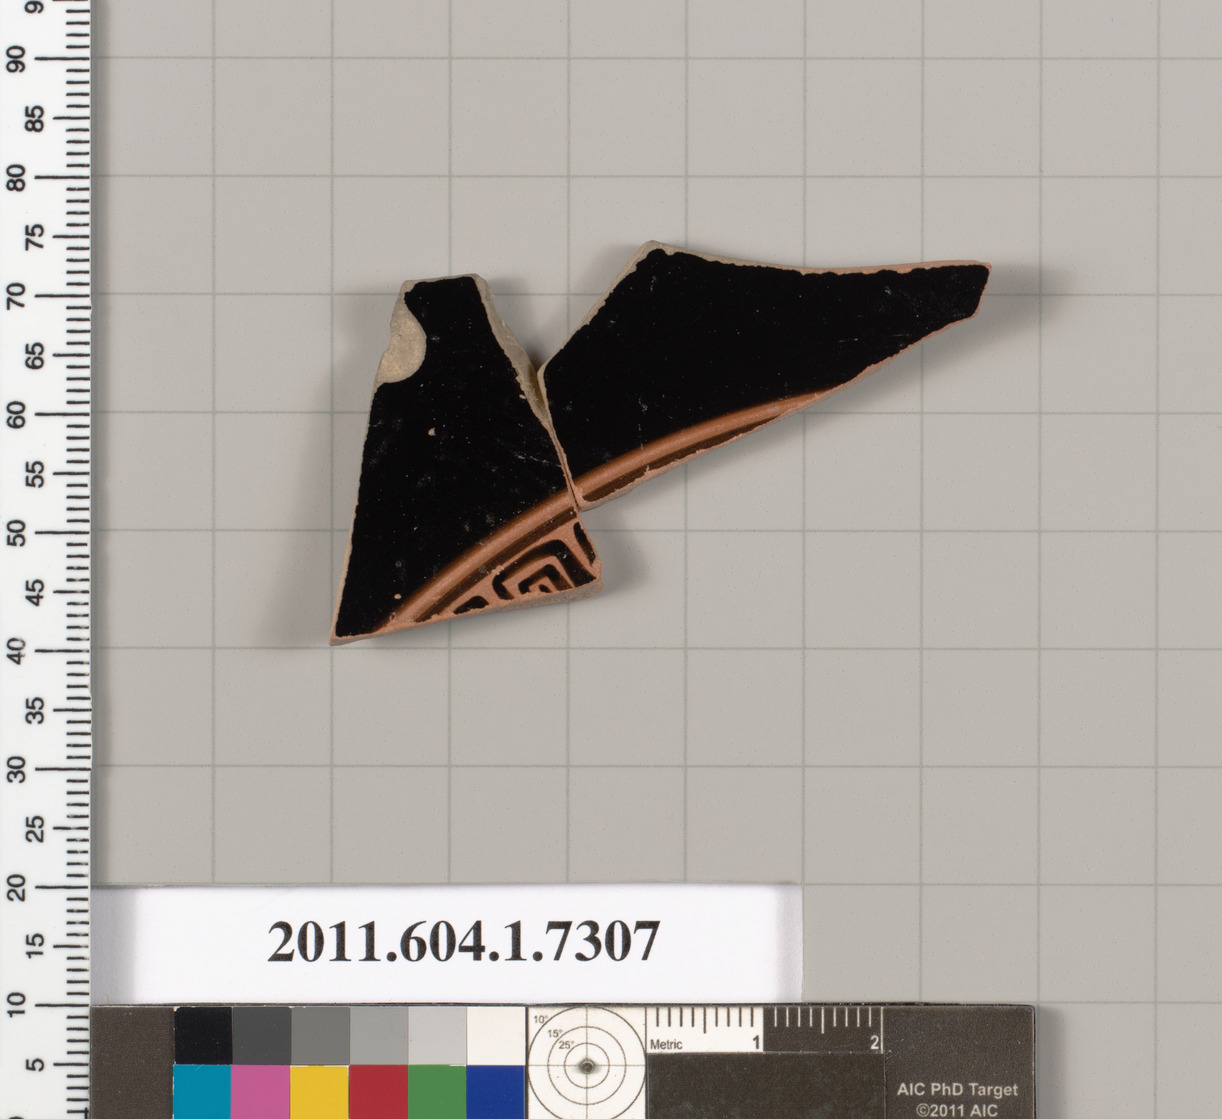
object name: kylix fragment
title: Terracotta fragment of a kylix (drinking cup)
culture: greek, attic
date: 500-480 BCE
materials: terracotta